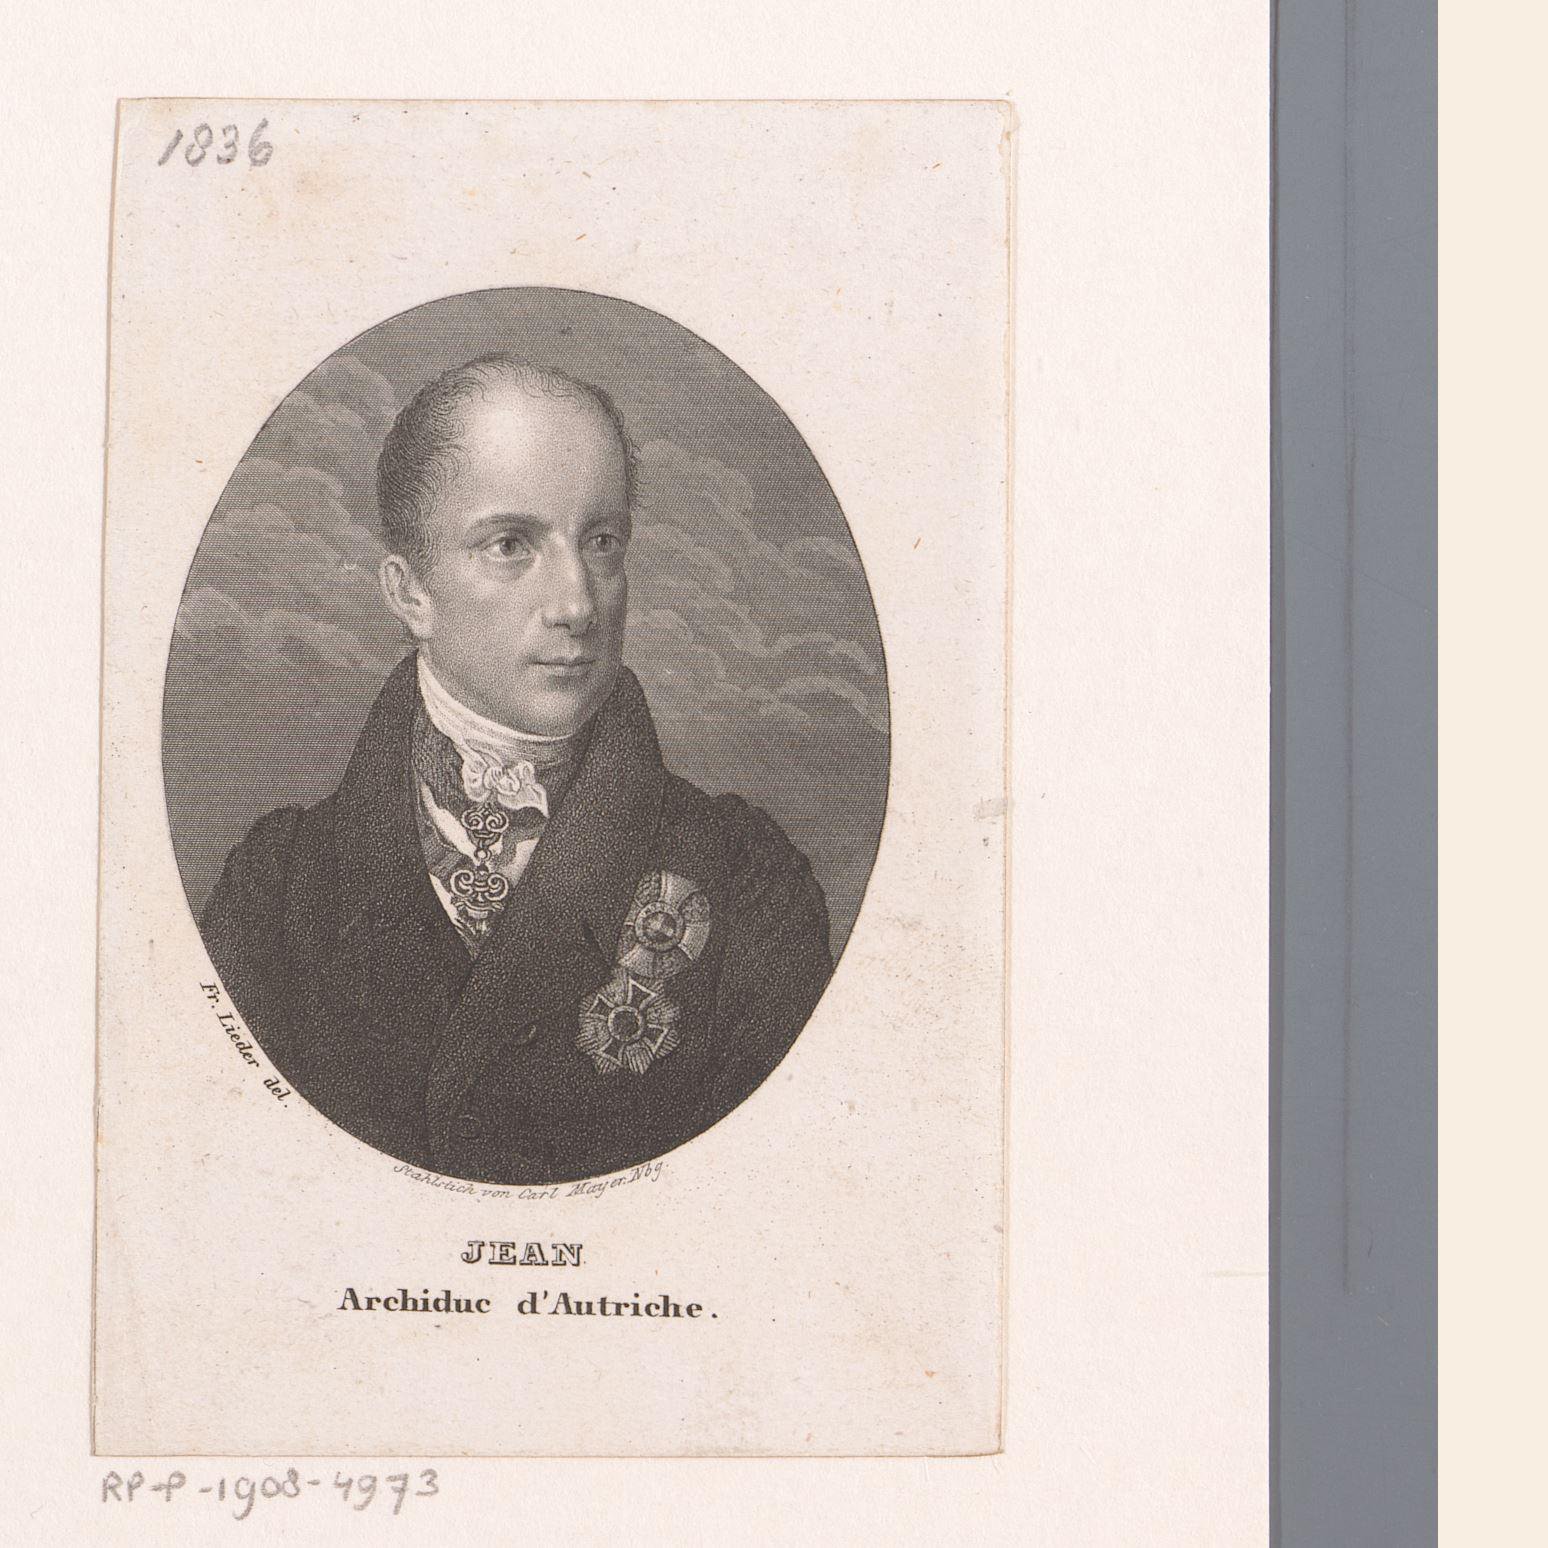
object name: print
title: Portret van Johann, aartshertog van Oostenrijk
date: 1836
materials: paper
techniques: engraving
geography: nuremberg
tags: historical persons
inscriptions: collector's mark: Lugt 2228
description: Vermoedelijk afkomstig uit: Almanach de Gotha, 1836.